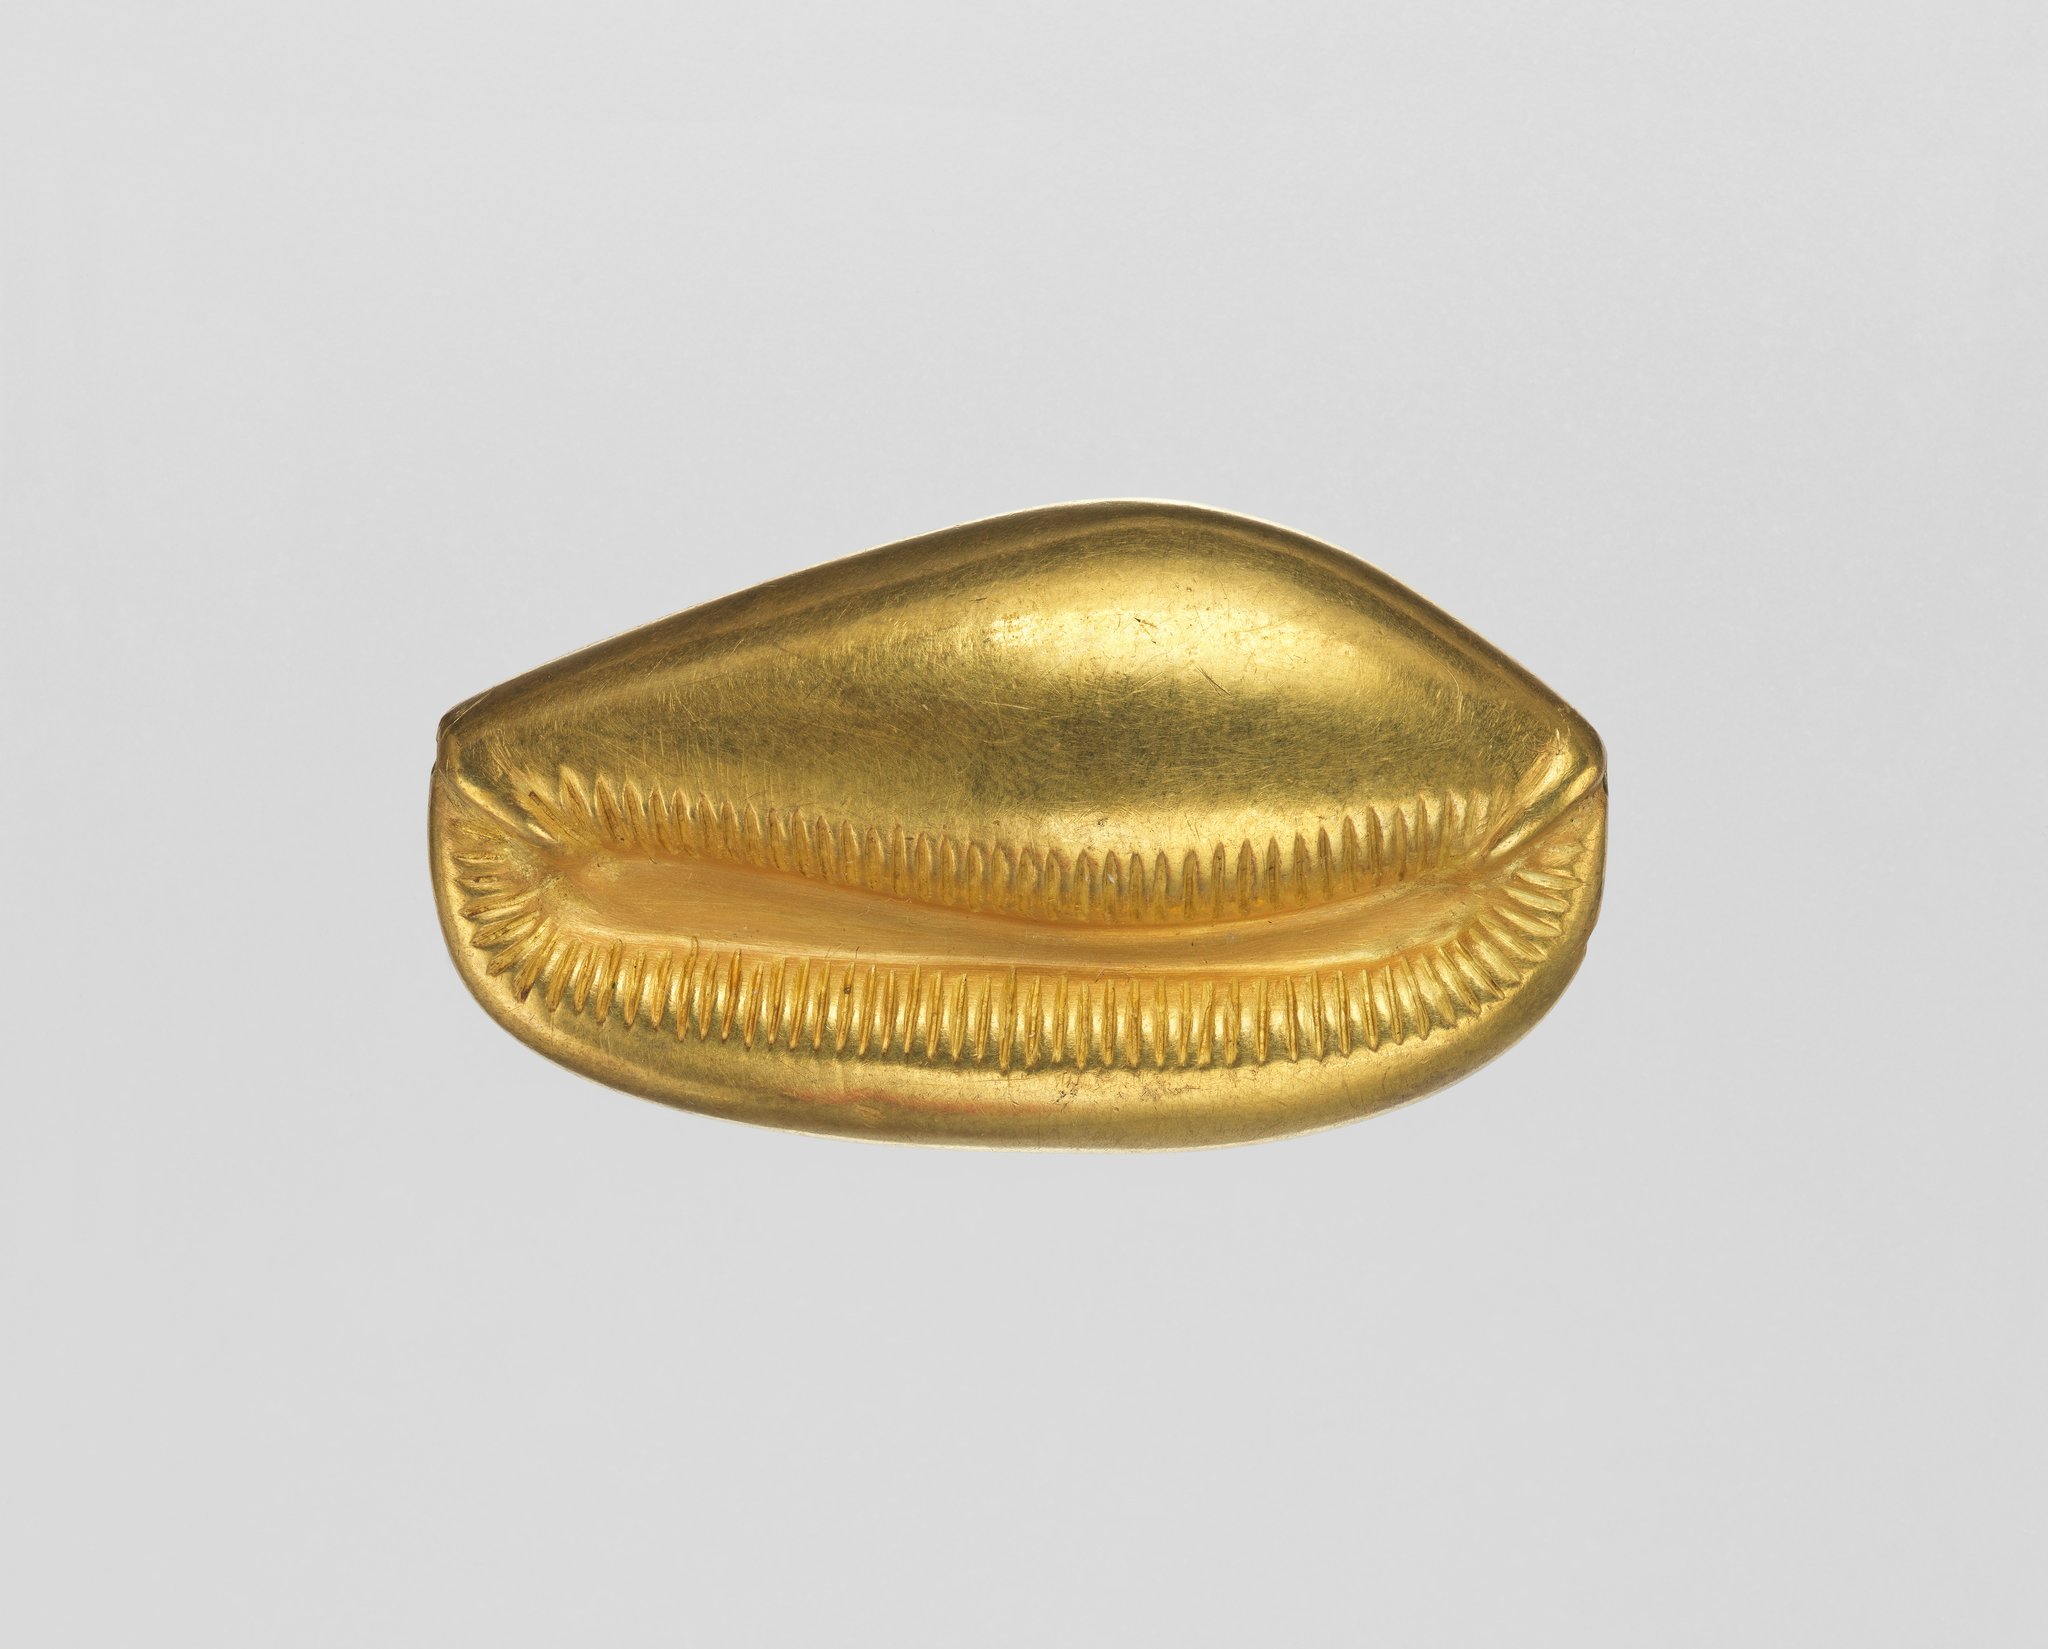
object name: jewelry element, cowrie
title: Cowrie shell bead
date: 1878-1840 BCE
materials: gold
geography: memphite region